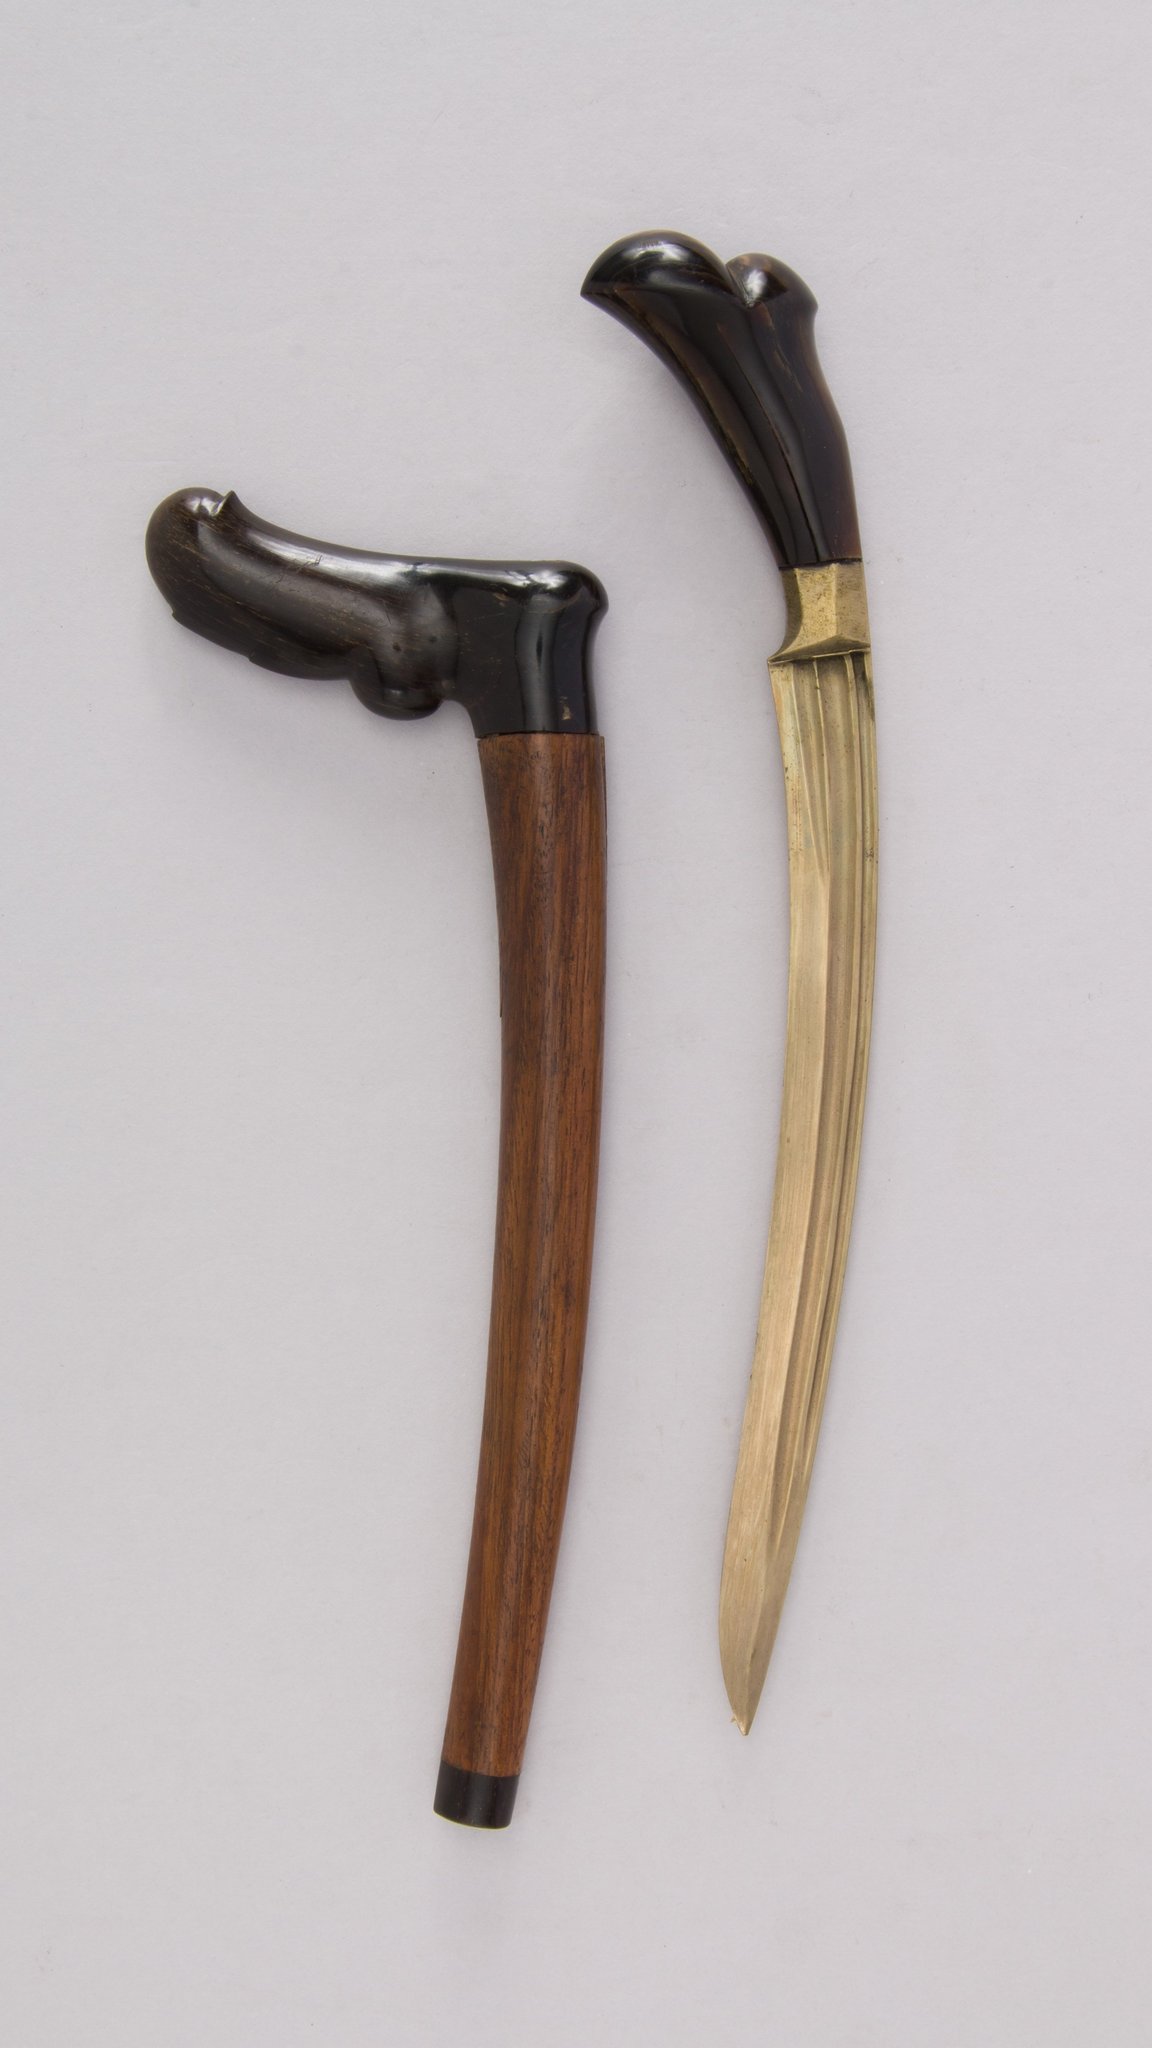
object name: knife bade bade with sheath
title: Knife (Bade-bade) with Sheath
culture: indonesian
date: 1701-1900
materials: brass, horn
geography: indonesia